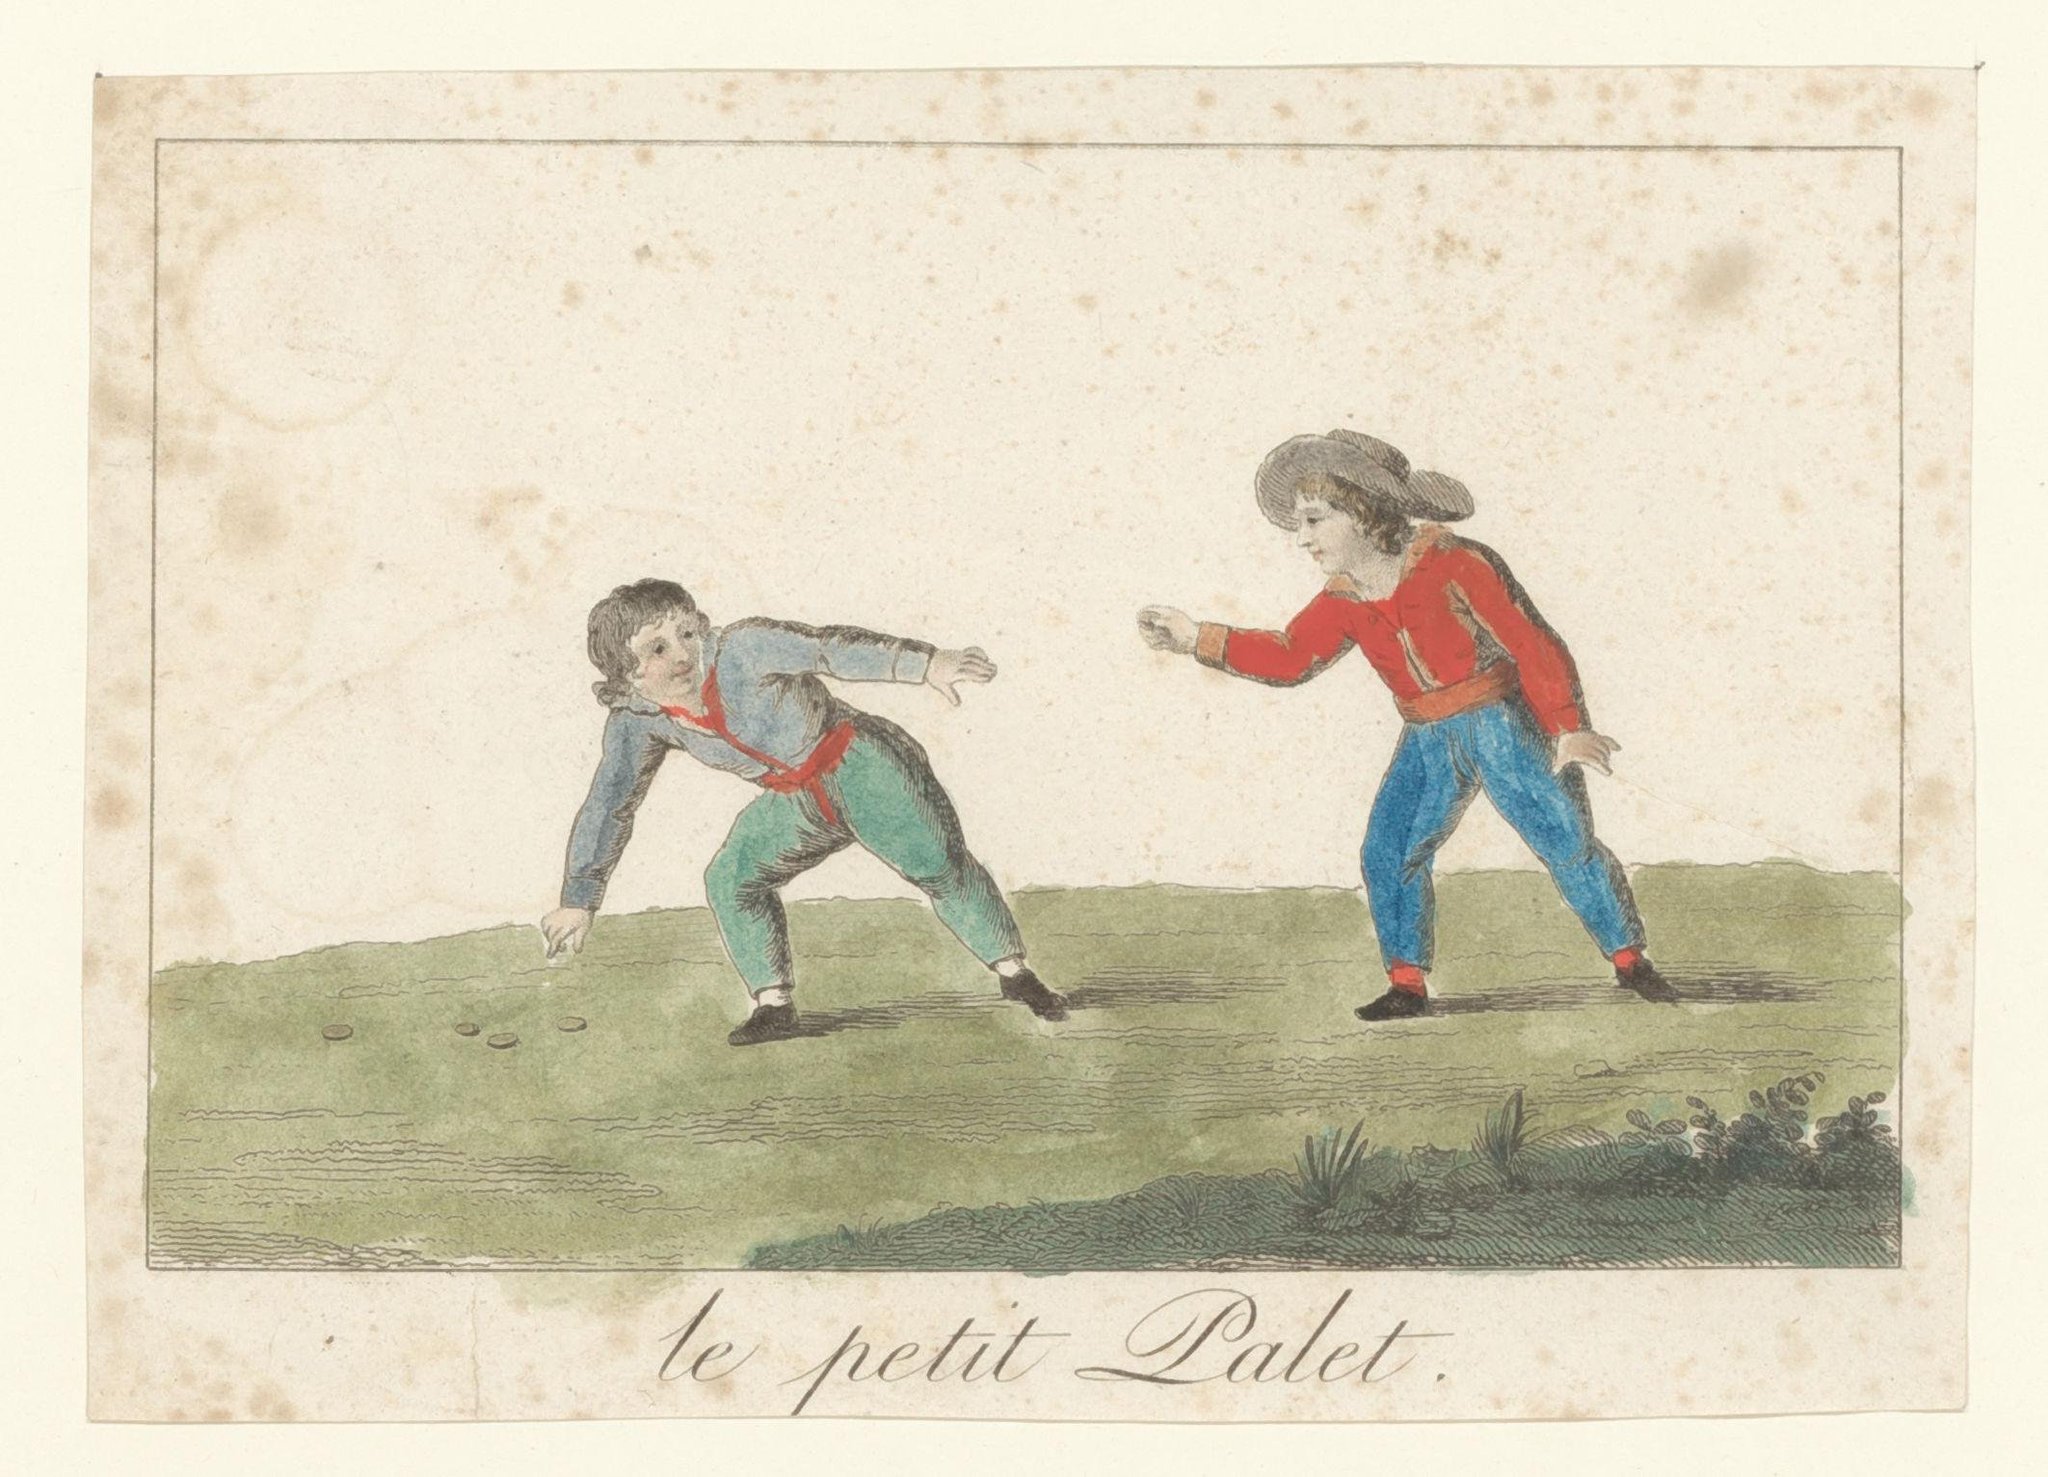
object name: print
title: Kinderen spelen een werpspel met kiezels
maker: Anonymous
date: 1800-1899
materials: paper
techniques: etching, hand coloring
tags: throwing games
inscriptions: stamp, collector's mark: Lugt 1641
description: Onderwerpsrubrieken binnen de Atlas Zeden en Gewoonten: Zeden en Gewoonten in Engeren Zin, Des menschen beging, midden en einde, Kinderleven – Kinderspel en Kinderprenten.